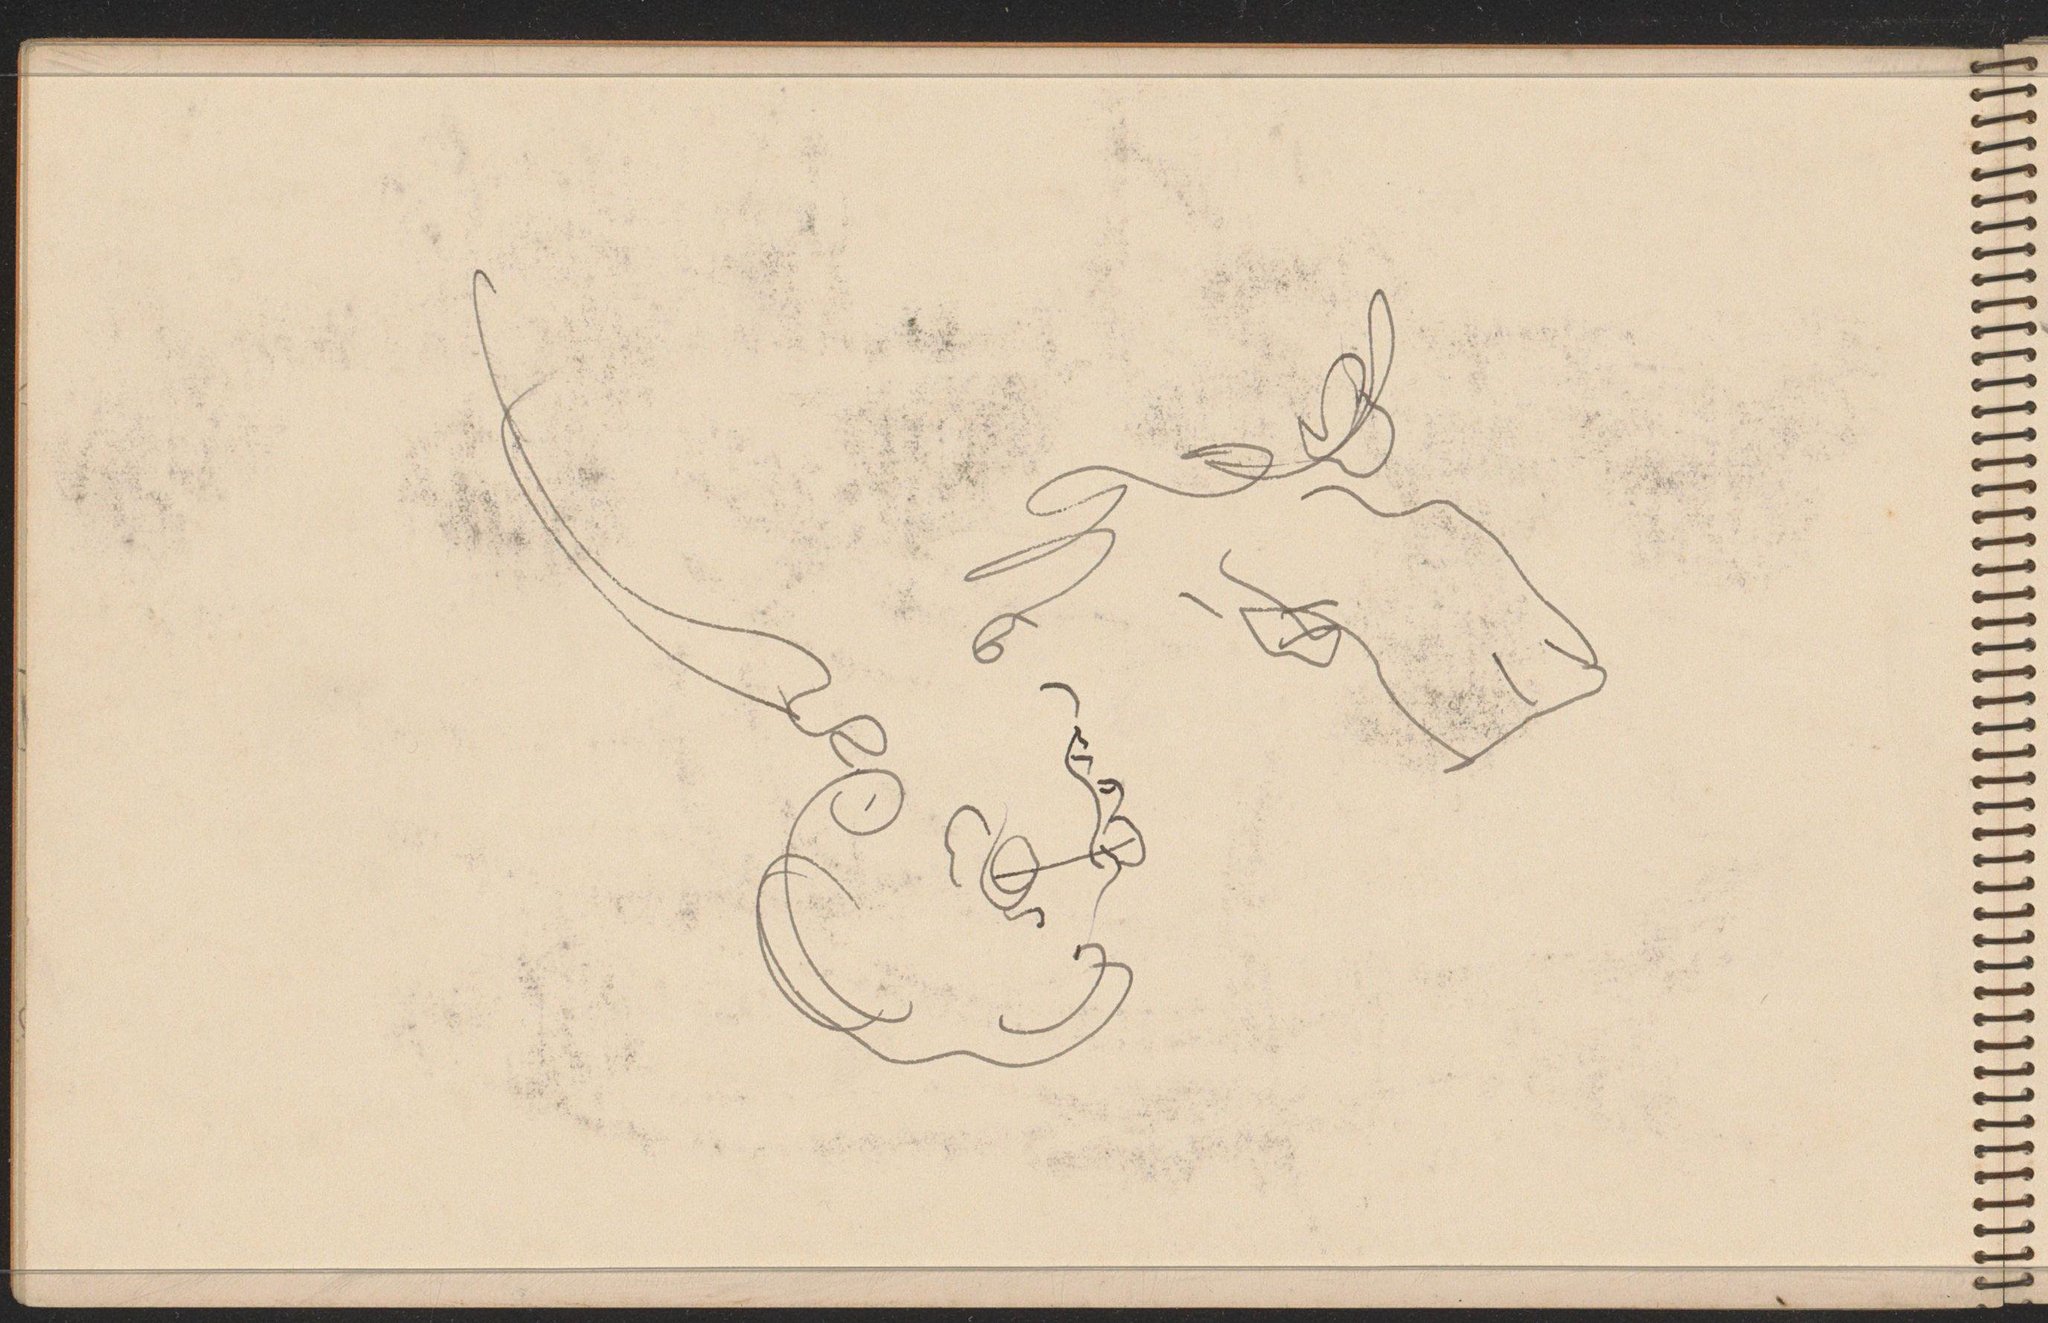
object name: sketchbook leaf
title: Lezende vrouw met een bril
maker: carel adolph lion cachet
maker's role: draughtsman, print maker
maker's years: 1864-1945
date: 1930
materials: ink, paper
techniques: pen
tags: eyeglasses, spectacles, adult woman, reading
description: Blad 3 verso uit een schetsboek met 14 bladen.